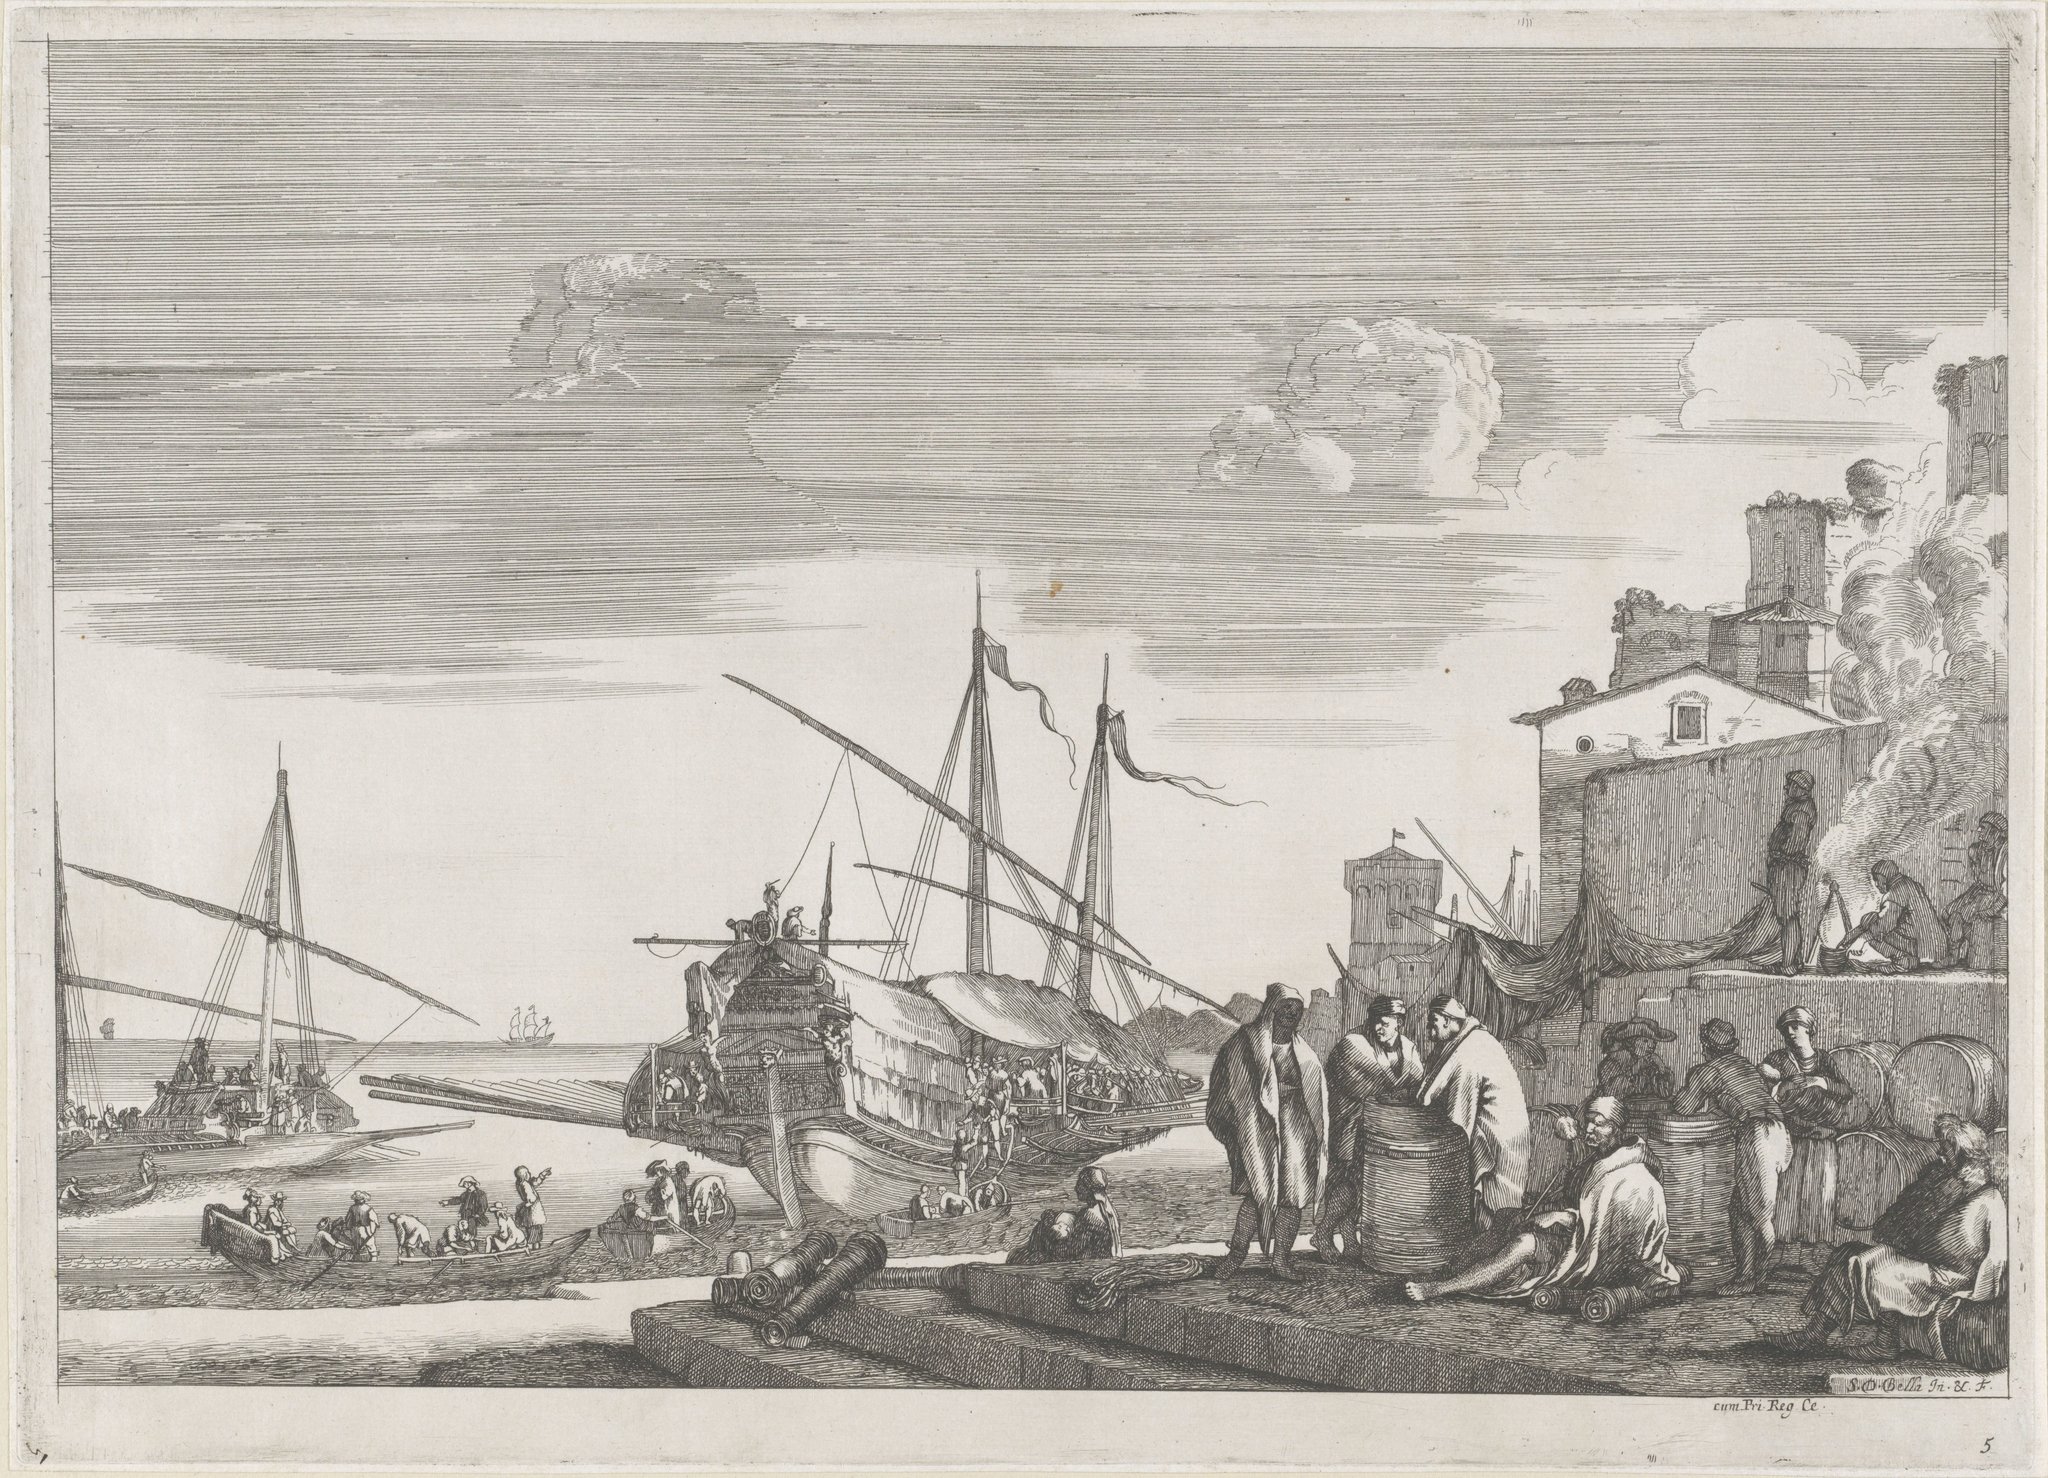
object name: print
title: Haven van Livorno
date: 1655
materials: paper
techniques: etching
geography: amsterdam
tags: harbour, dock labourer, ships (in general), piece of sculpture, reproduction of a piece of sculpture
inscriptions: collector's mark: Lugt 10, collector's mark: Lugt 11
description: Zicht op de haven van Livorno met twee galeischepen. Op de kade rechts staan havenarbeiders en handelaren. Op de achtergrond rechts gebouwen en een toren aan de kust.